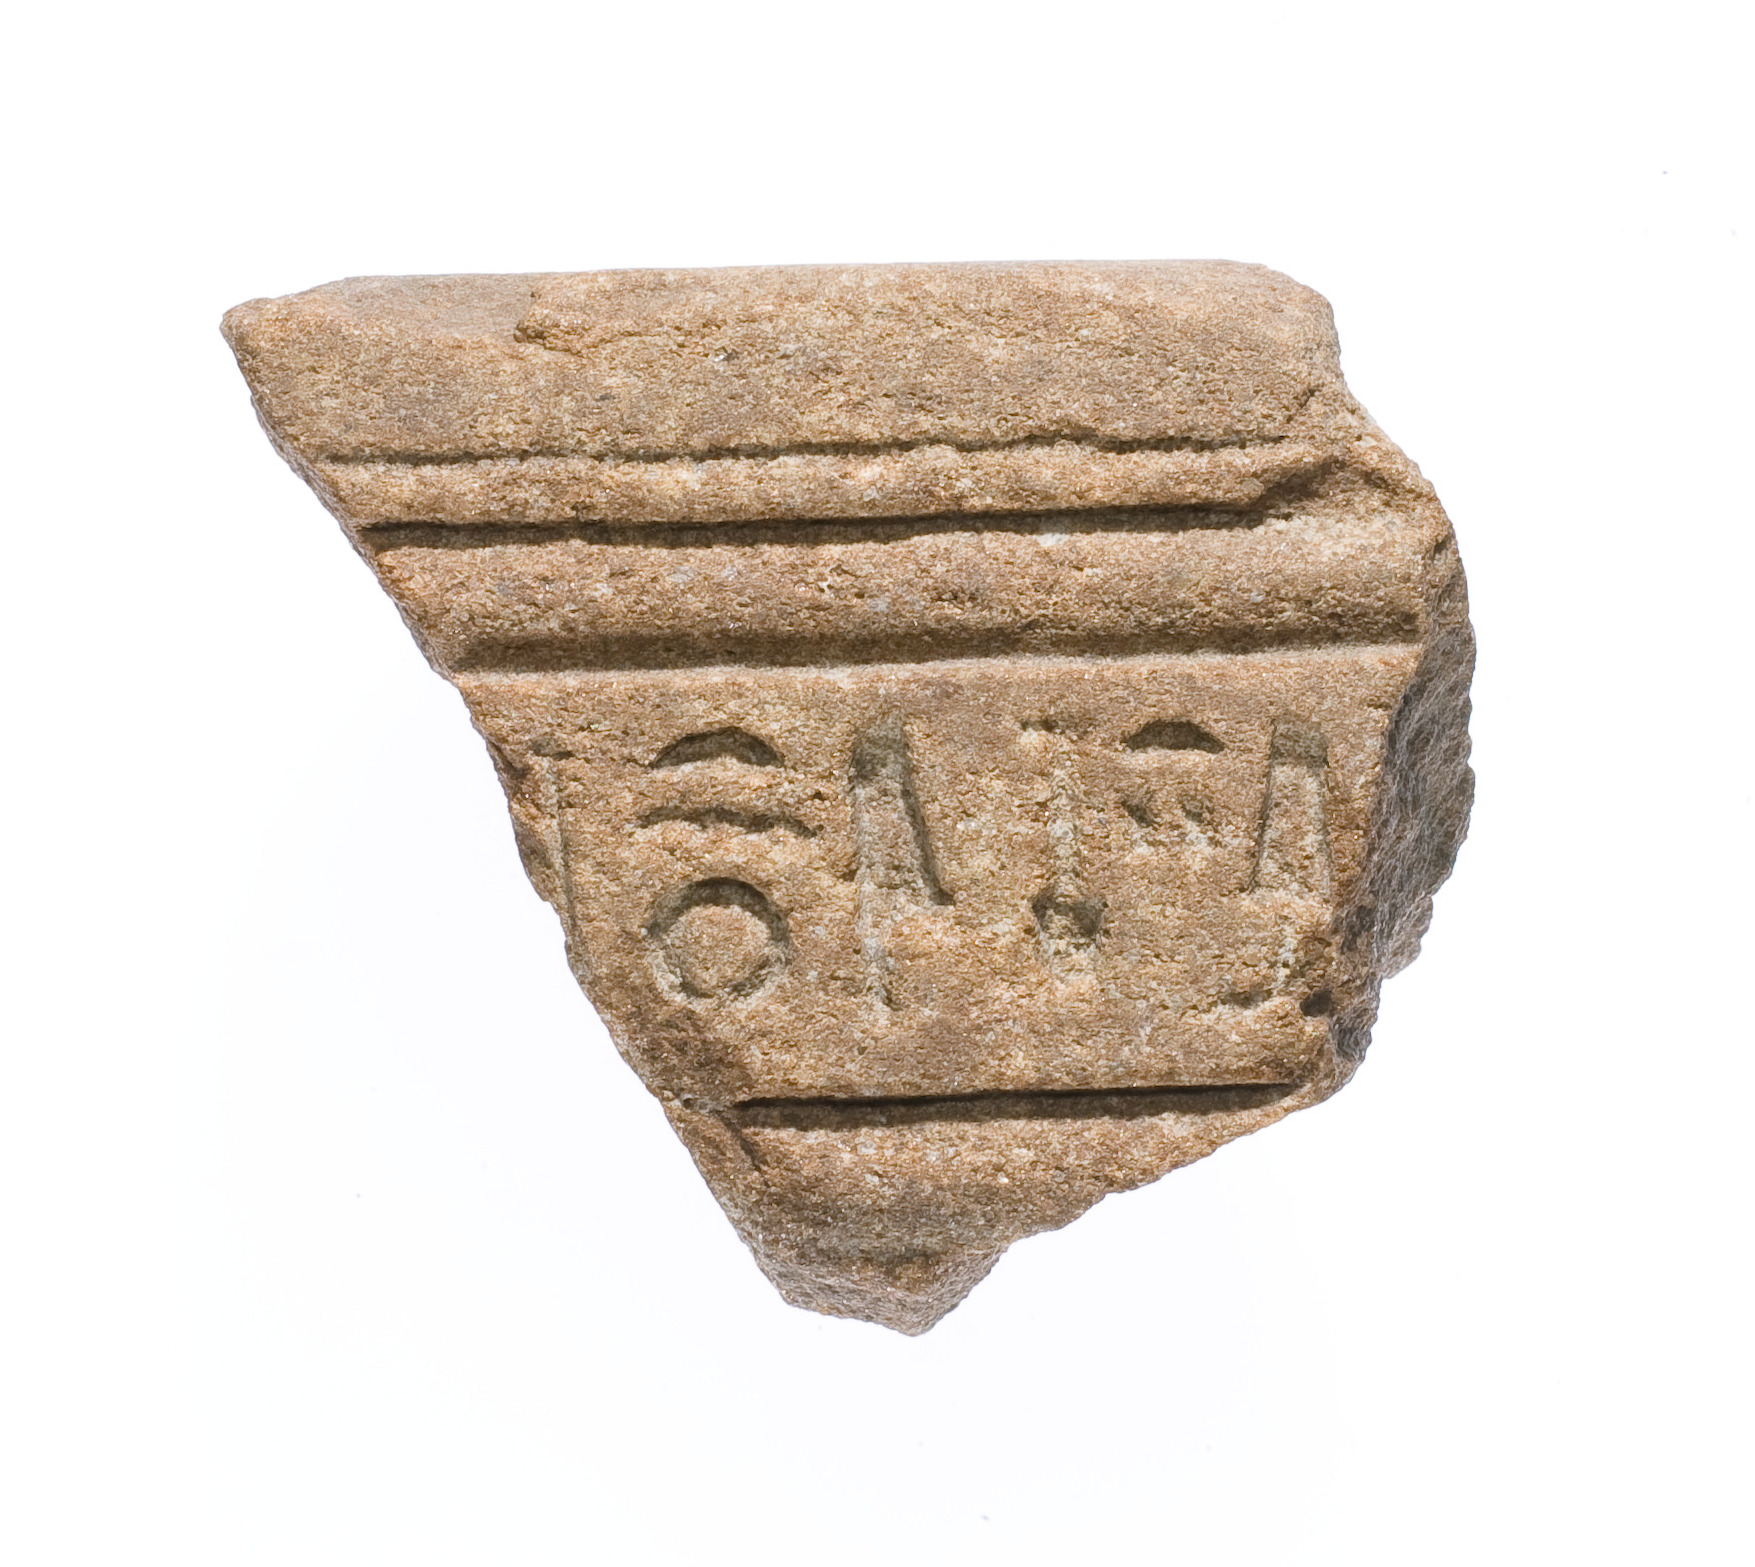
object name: edge of a block with cartouche of nefertiti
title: Block fragment with the cartouche of Nefertiti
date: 1353-1336 BCE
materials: quartzite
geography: egypt